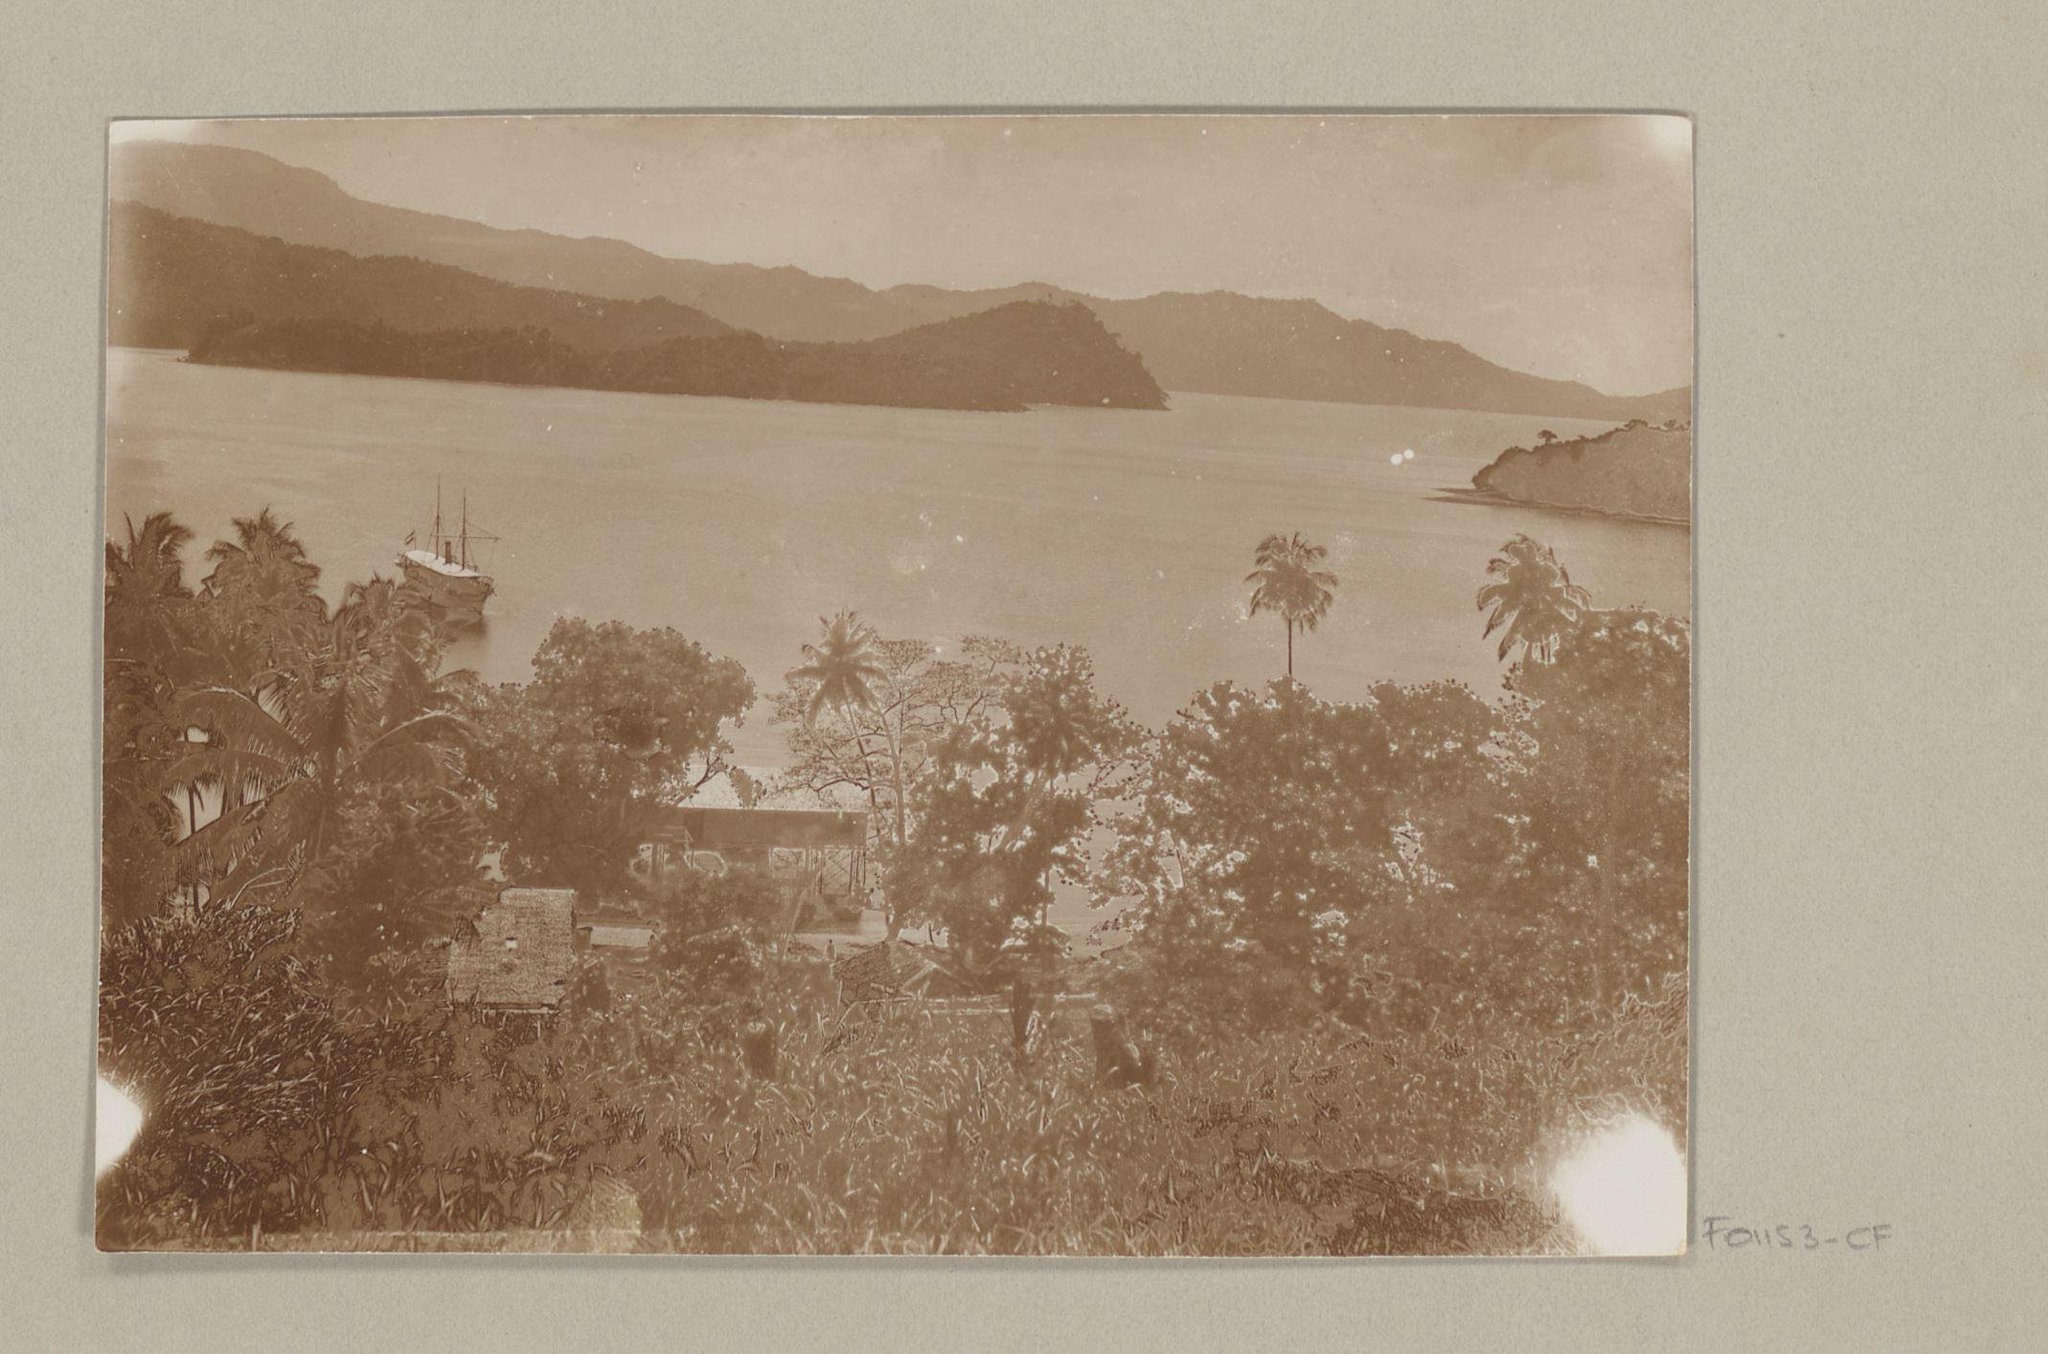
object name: album leaf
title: Schip in een baai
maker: Anonymous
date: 1880-1900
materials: photographic support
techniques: collodion silver print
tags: gulf, bay, ships (in general), trees: palm-tree, dutch east indies, the